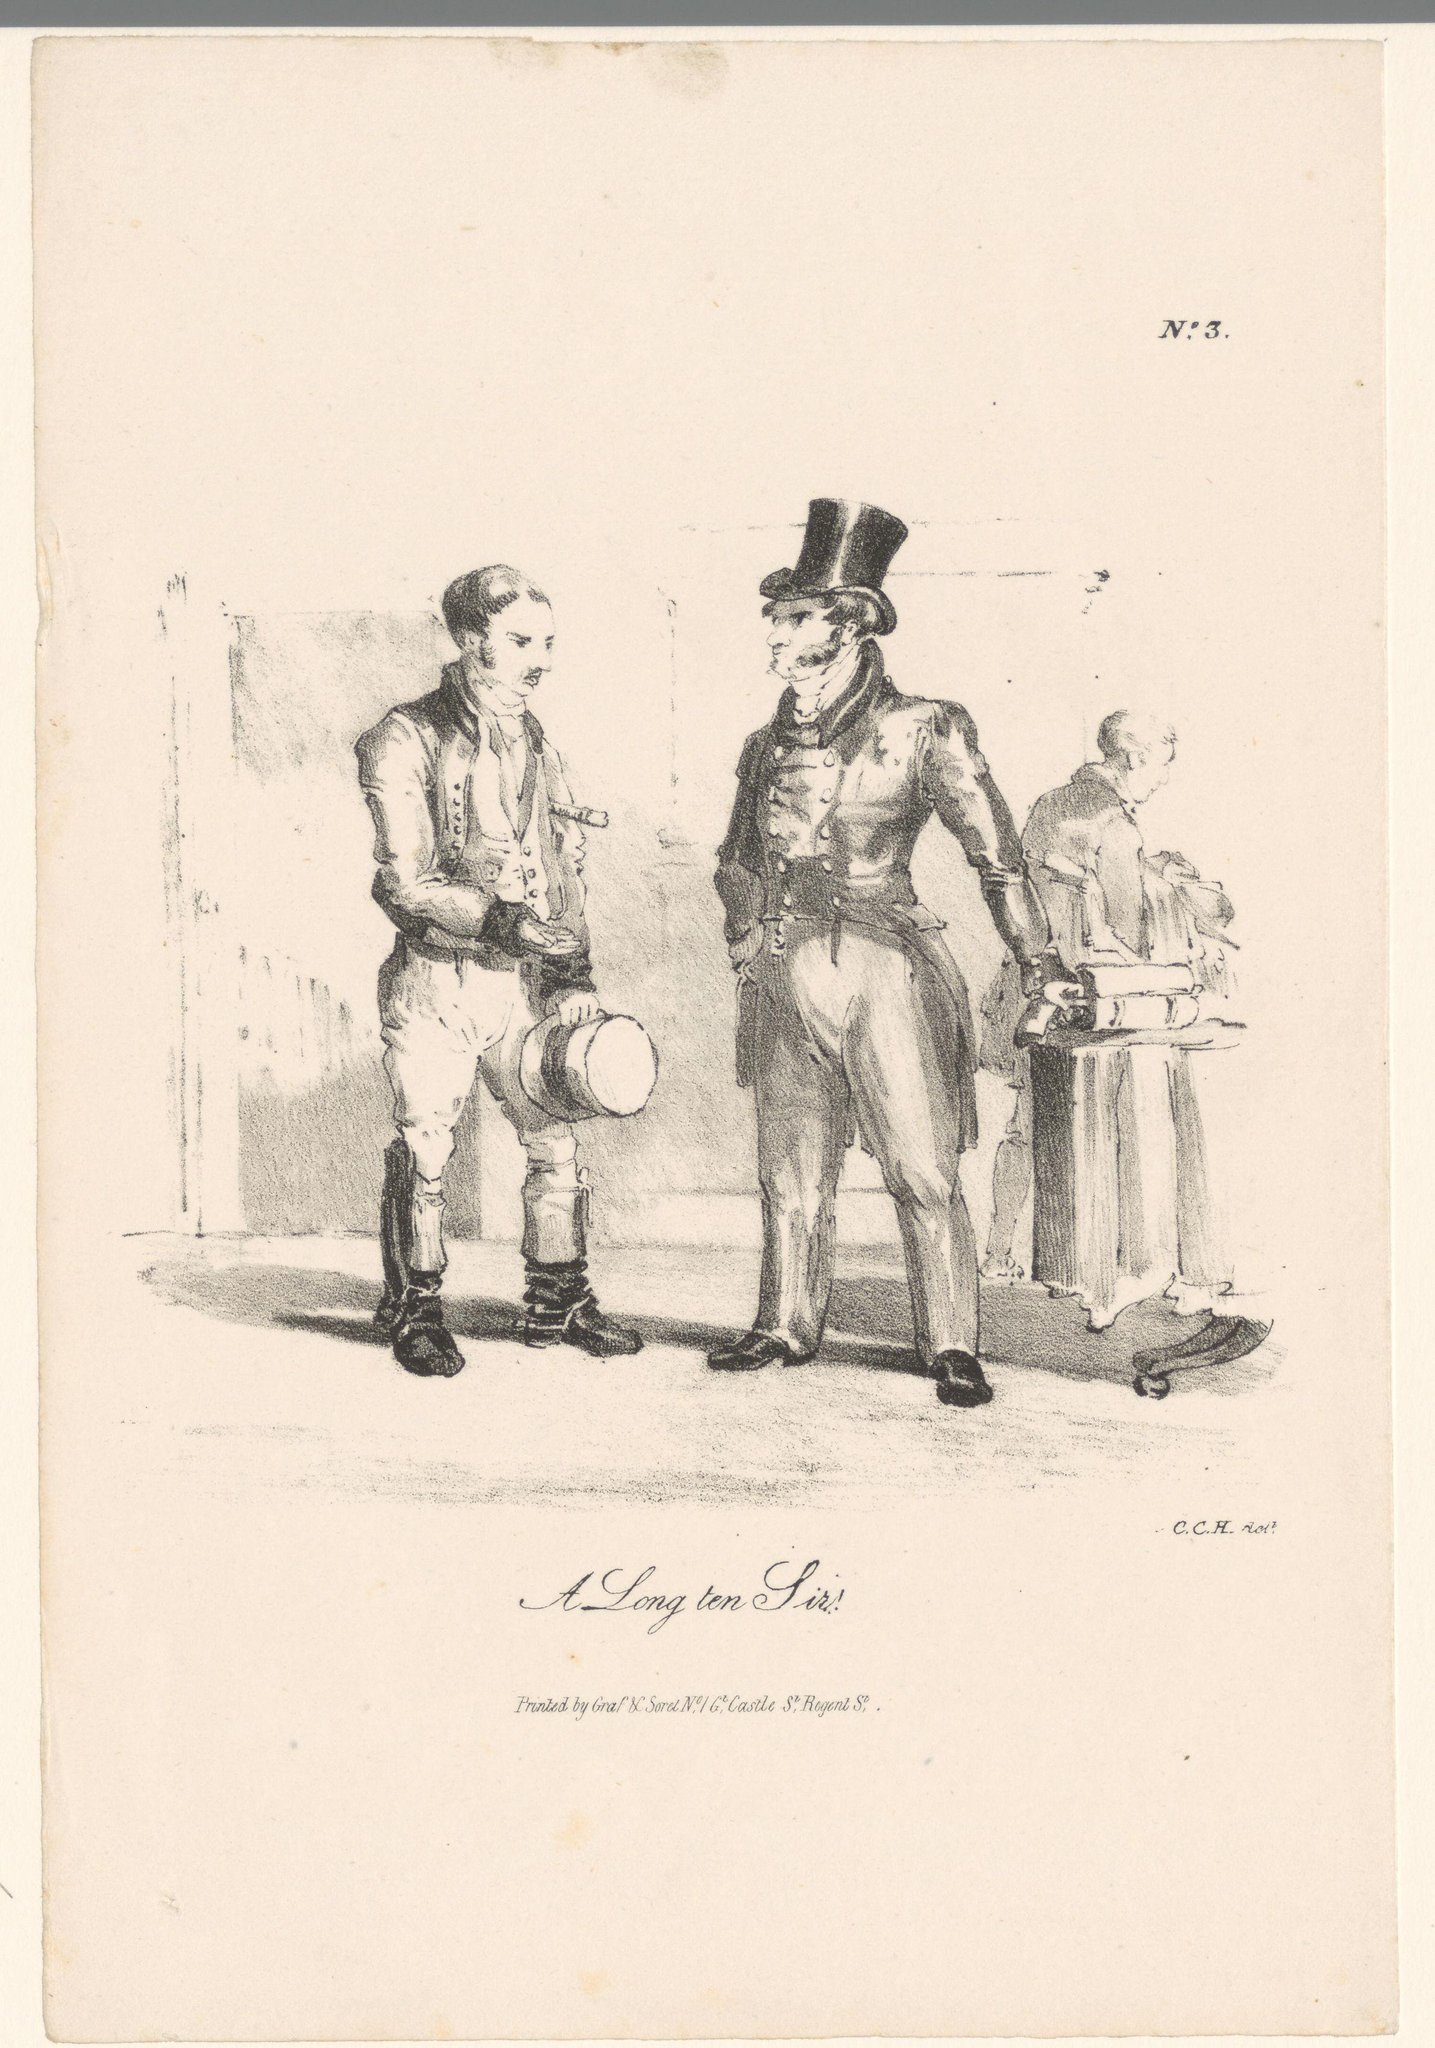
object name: cartoon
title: Diverse spotprenten over de Engelse bevolking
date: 1830-1838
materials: paper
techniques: lithograph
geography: london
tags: adult man (+ two persons), political caricatures and satires, head-gear: top hat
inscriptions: collector's mark: Lugt 2228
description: Prent maakt deel uit van een serie met spotprenten. Over deze serie is verder niets bekend. Het betreft voornamelijk voorstellingen over de Engelse bevolking.